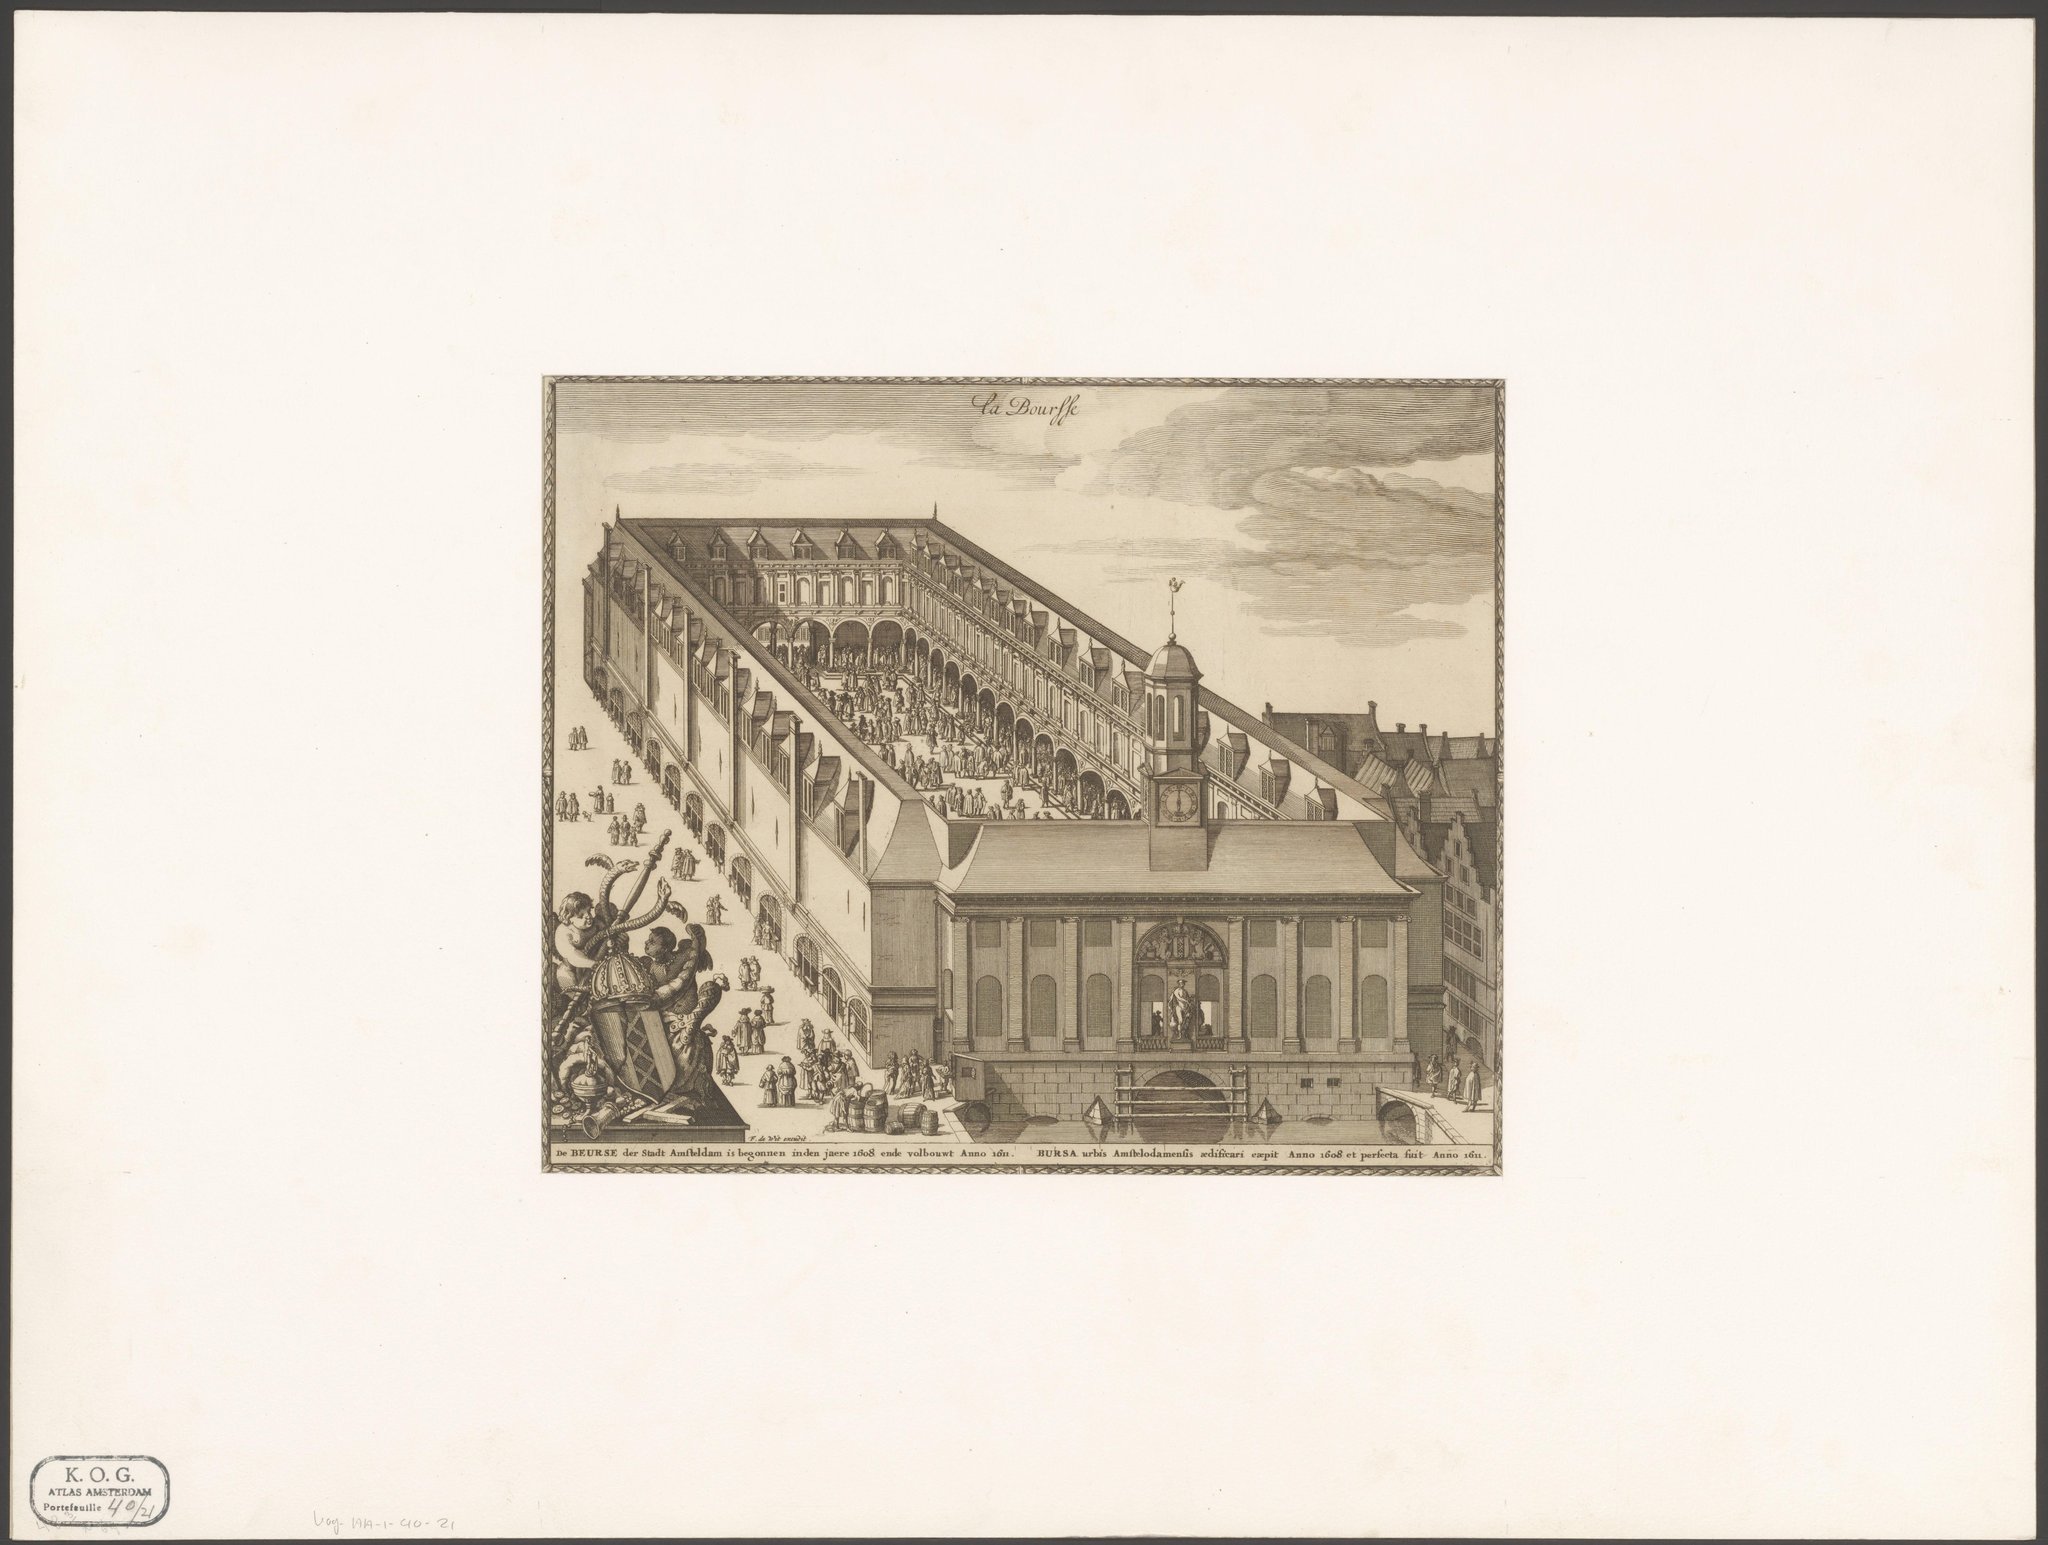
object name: print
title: Vogelvluchtgezicht op de Beurs van Hendrik de Keyser te Amsterdam, na 1668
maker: Anonymous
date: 1668-1728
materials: paper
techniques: engraving, etching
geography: northern netherlands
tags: coat of arms (as symbol of the state, etc.) (+ city; municipal), stock exchange, stock-market, courtyard, caduceus (staff with two snakes, attribute of mercury), street (+ city(-scape) with figures, staffage)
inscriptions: collector's mark: Lugt 1641b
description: Prent mogelijk uit: La Celebre Ville d'Amsterdam (...) / De Heerlykheid der Wyd-vermaerde Stad Amsterdam (…). Leiden: Pieter (I) van der Aa, s.a. Of uit: Europa. Leiden: Pieter (I) van der Aa, [ca. 1715]. Of uit: La Galerie Agreable du Monde (...). Leiden: Pieter (I) van der Aa, 1728, dl. 17.